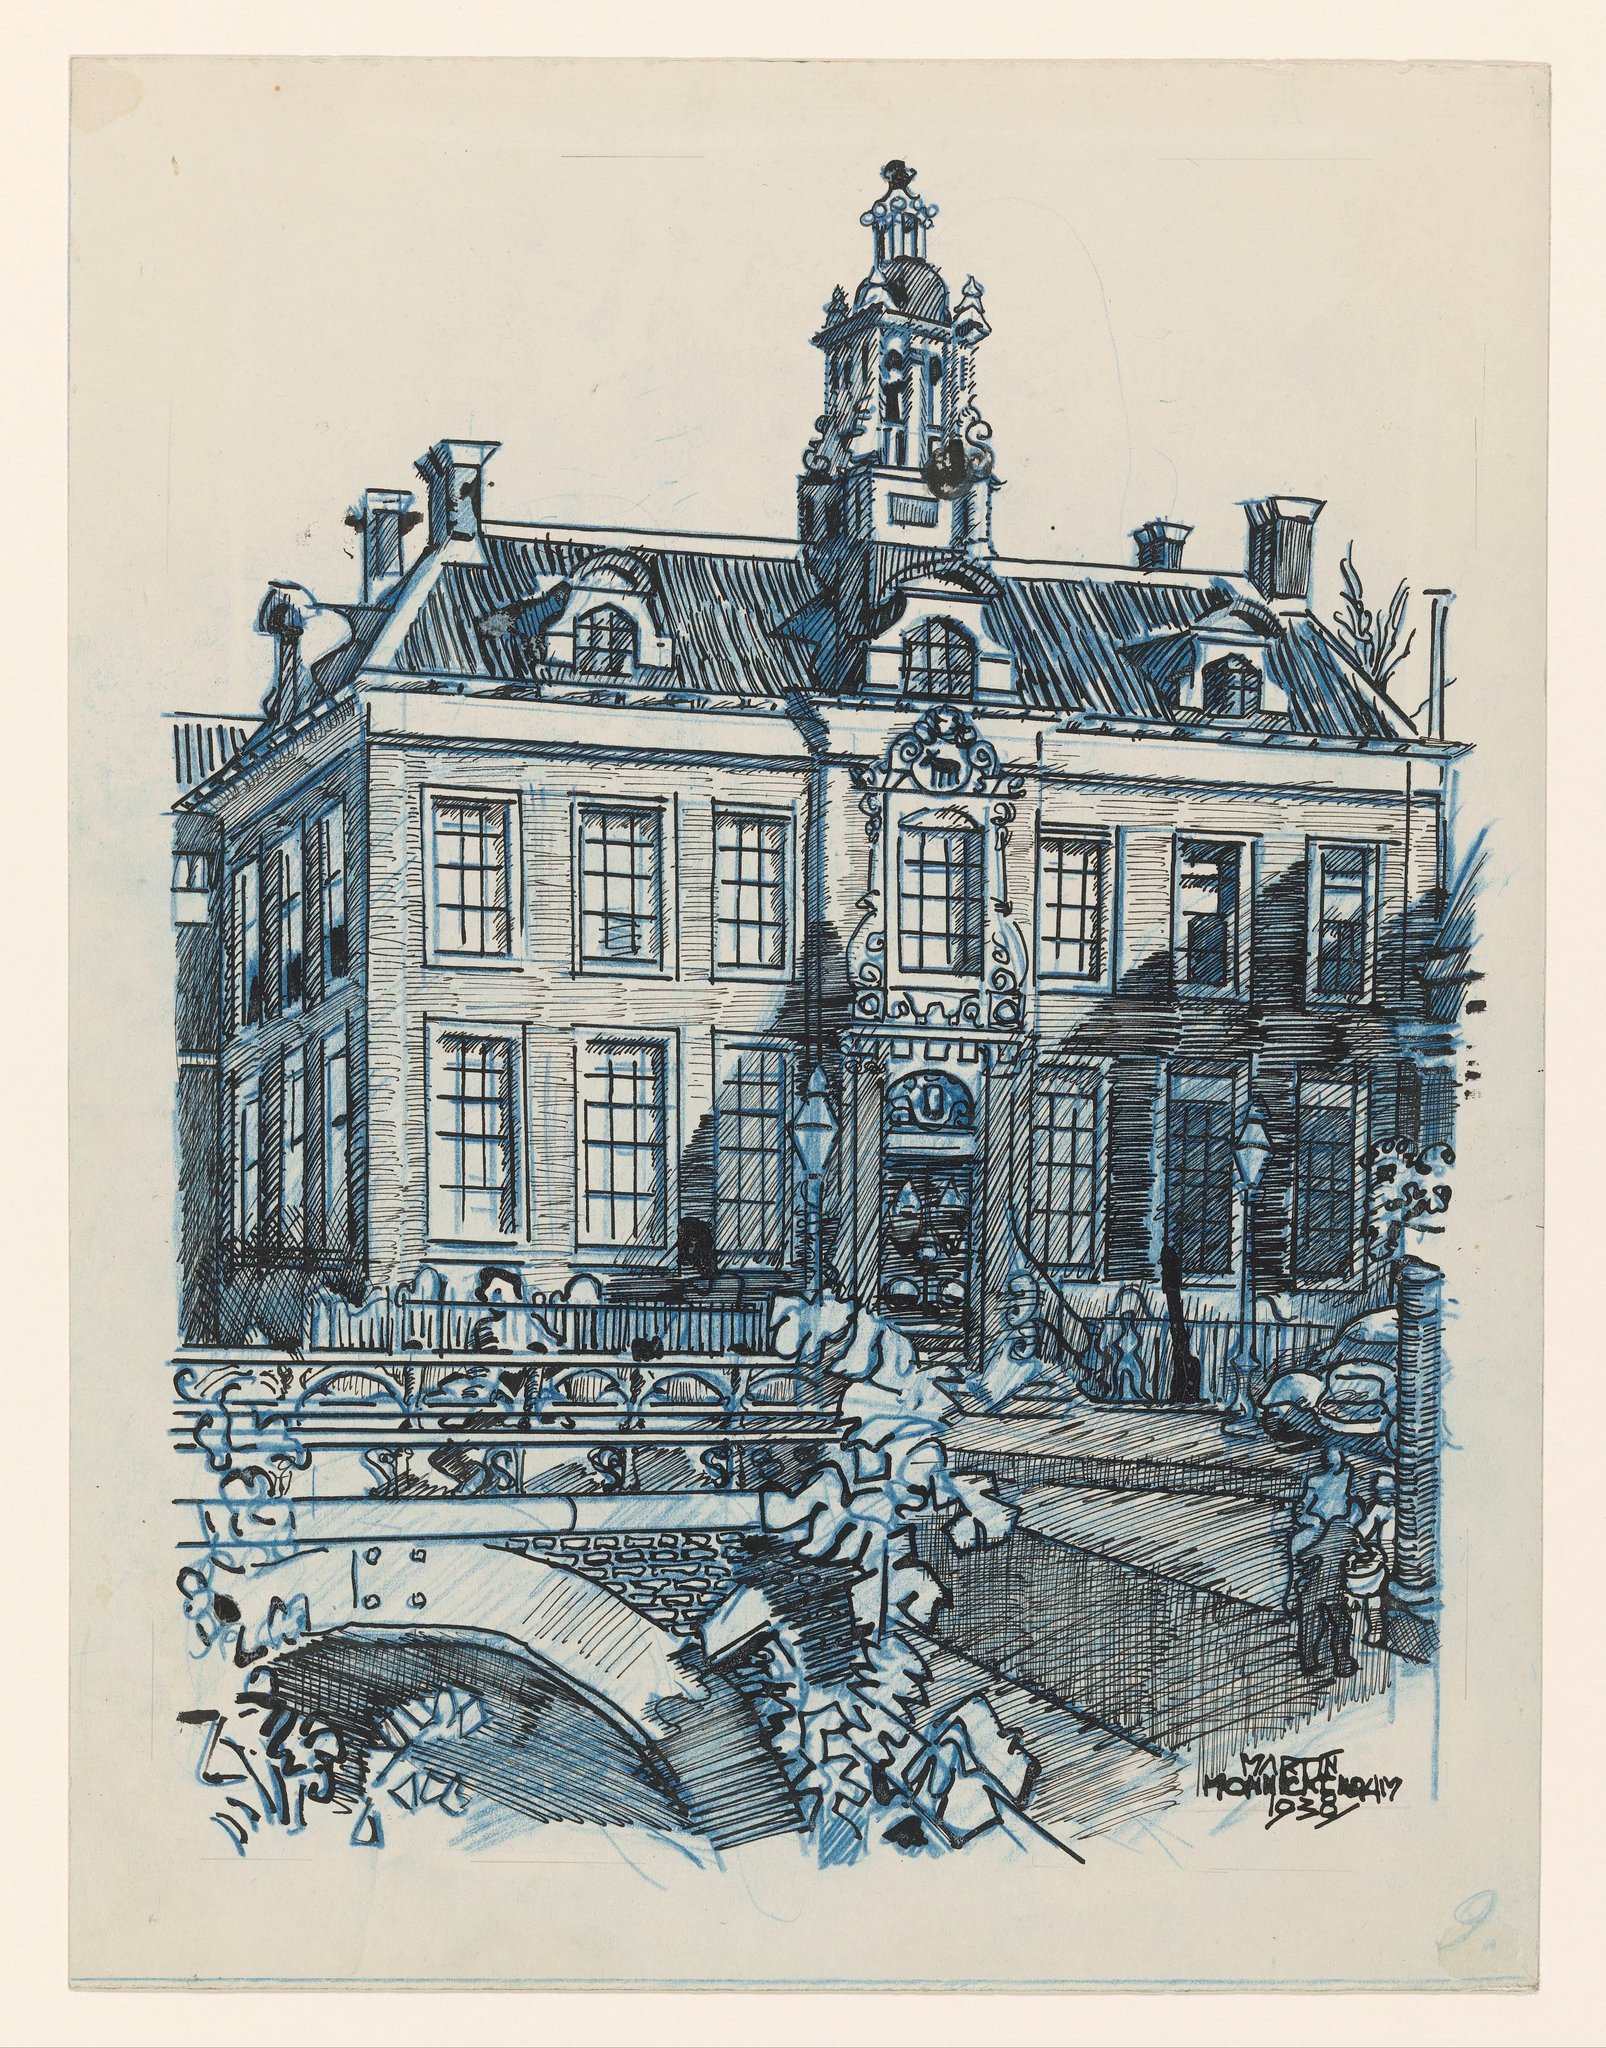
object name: drawing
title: Stadhuis te Edam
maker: martin monnickendam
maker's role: draughtsman, painter, print maker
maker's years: 1874-1943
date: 1938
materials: ink, paper, pencil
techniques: pen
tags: townhall